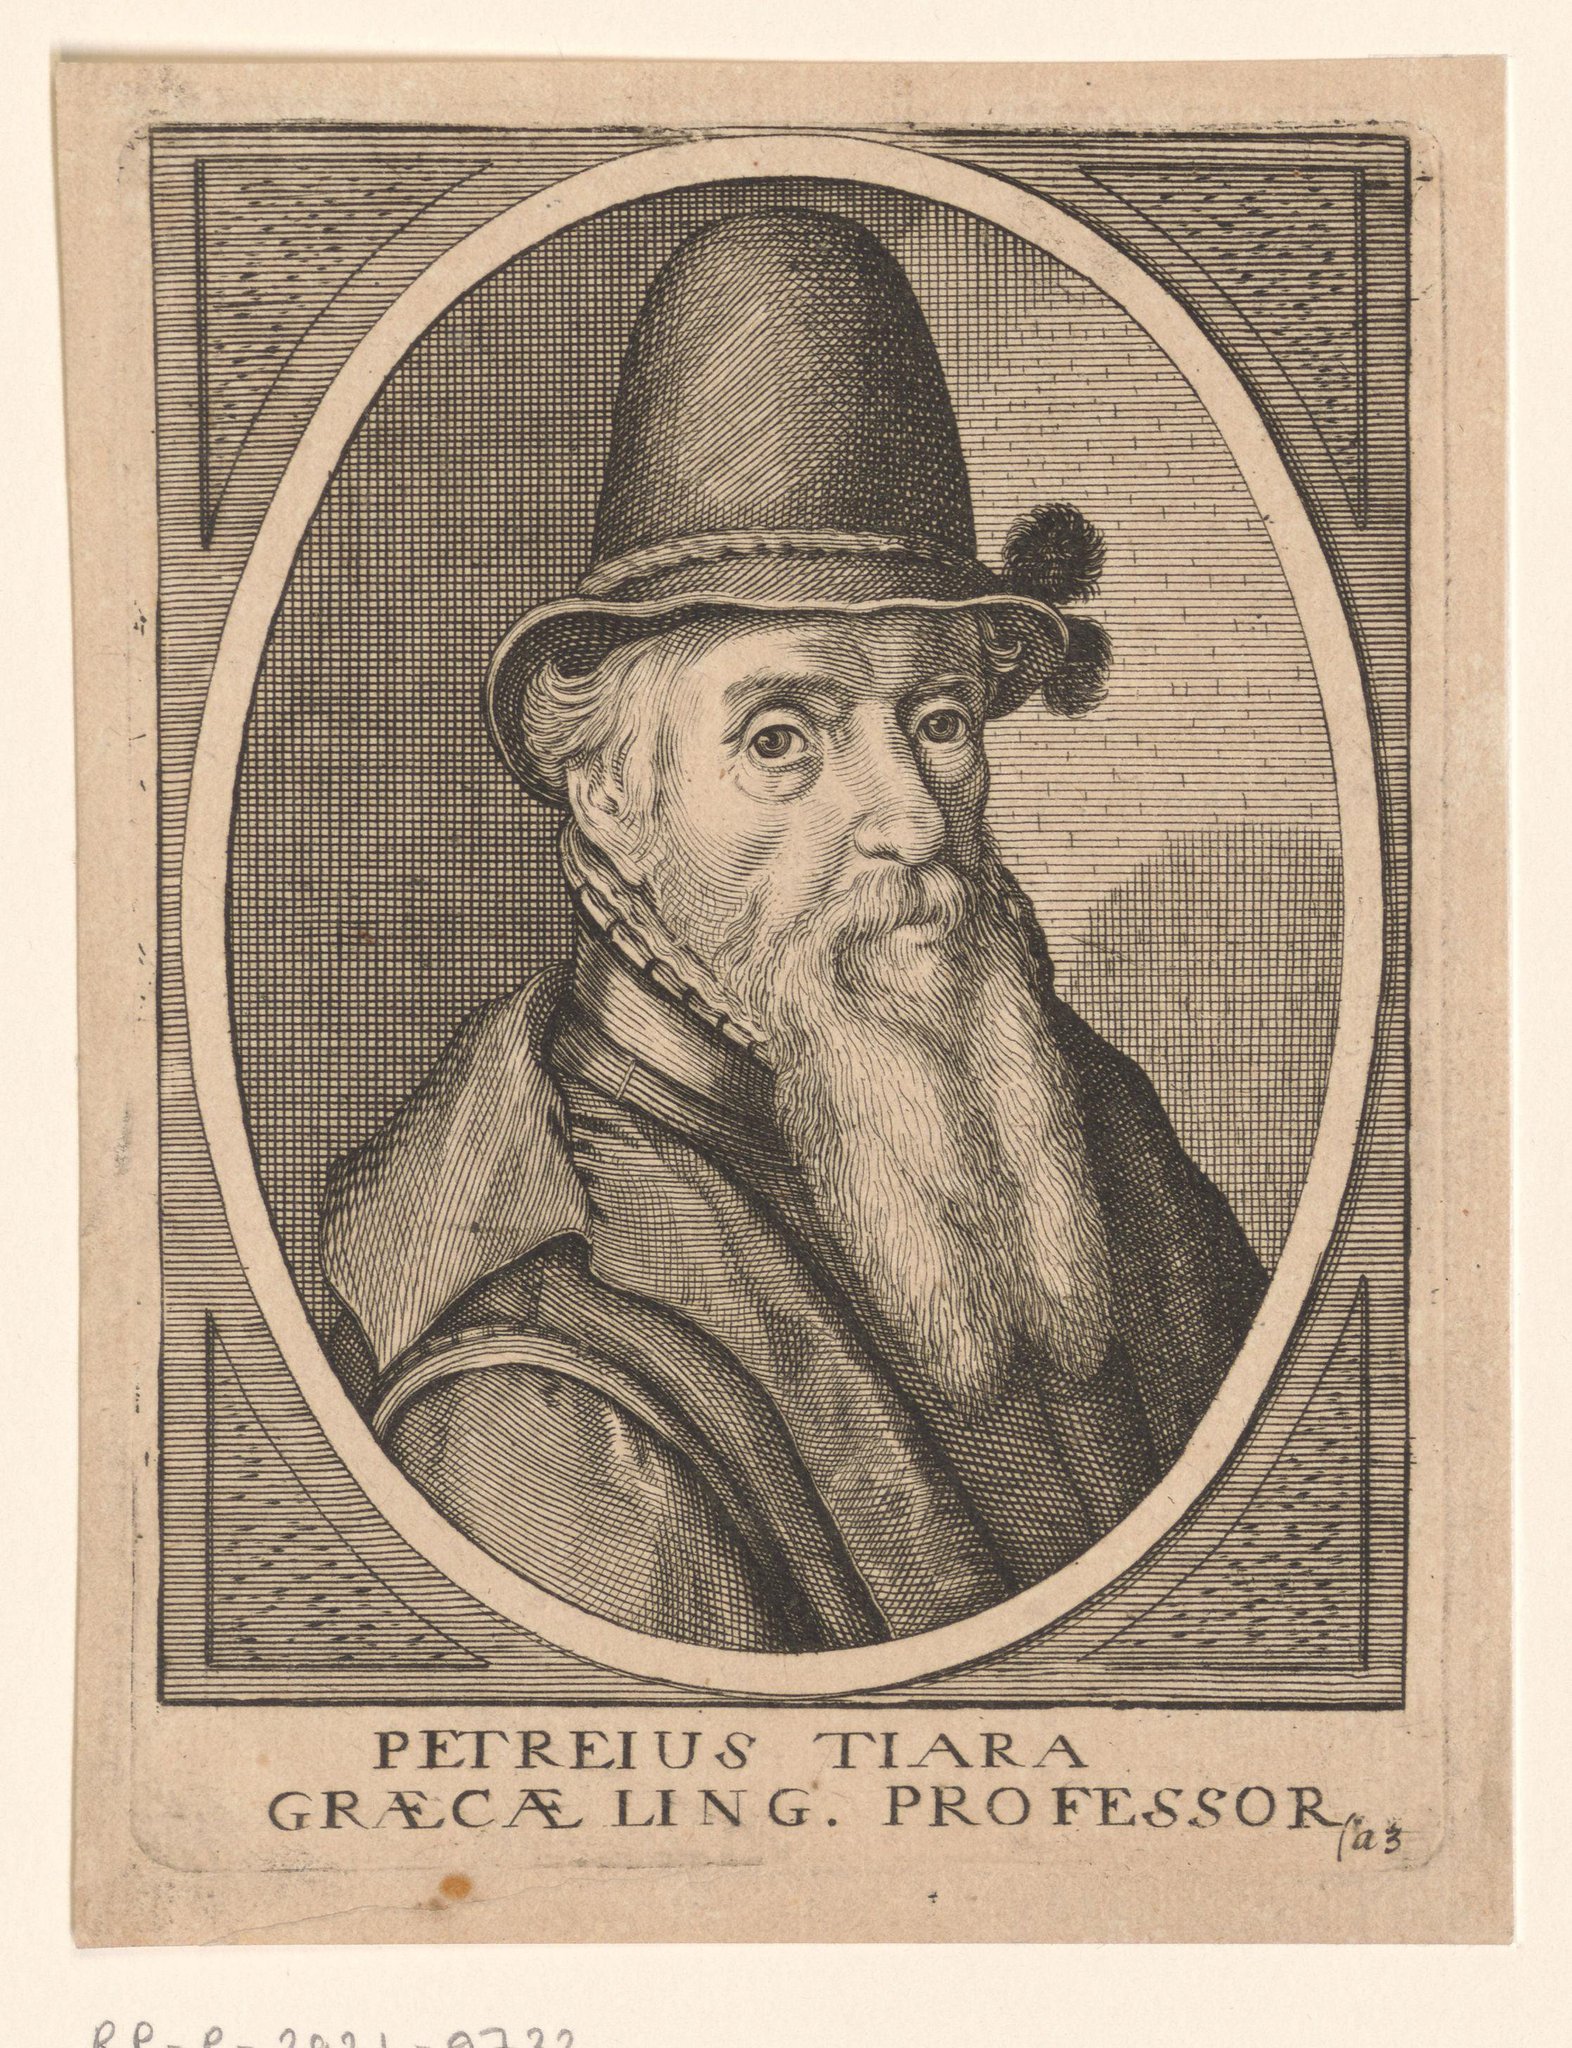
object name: print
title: Portretten van geleerden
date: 1650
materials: paper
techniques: engraving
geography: frankfurt am main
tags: historical persons, professor